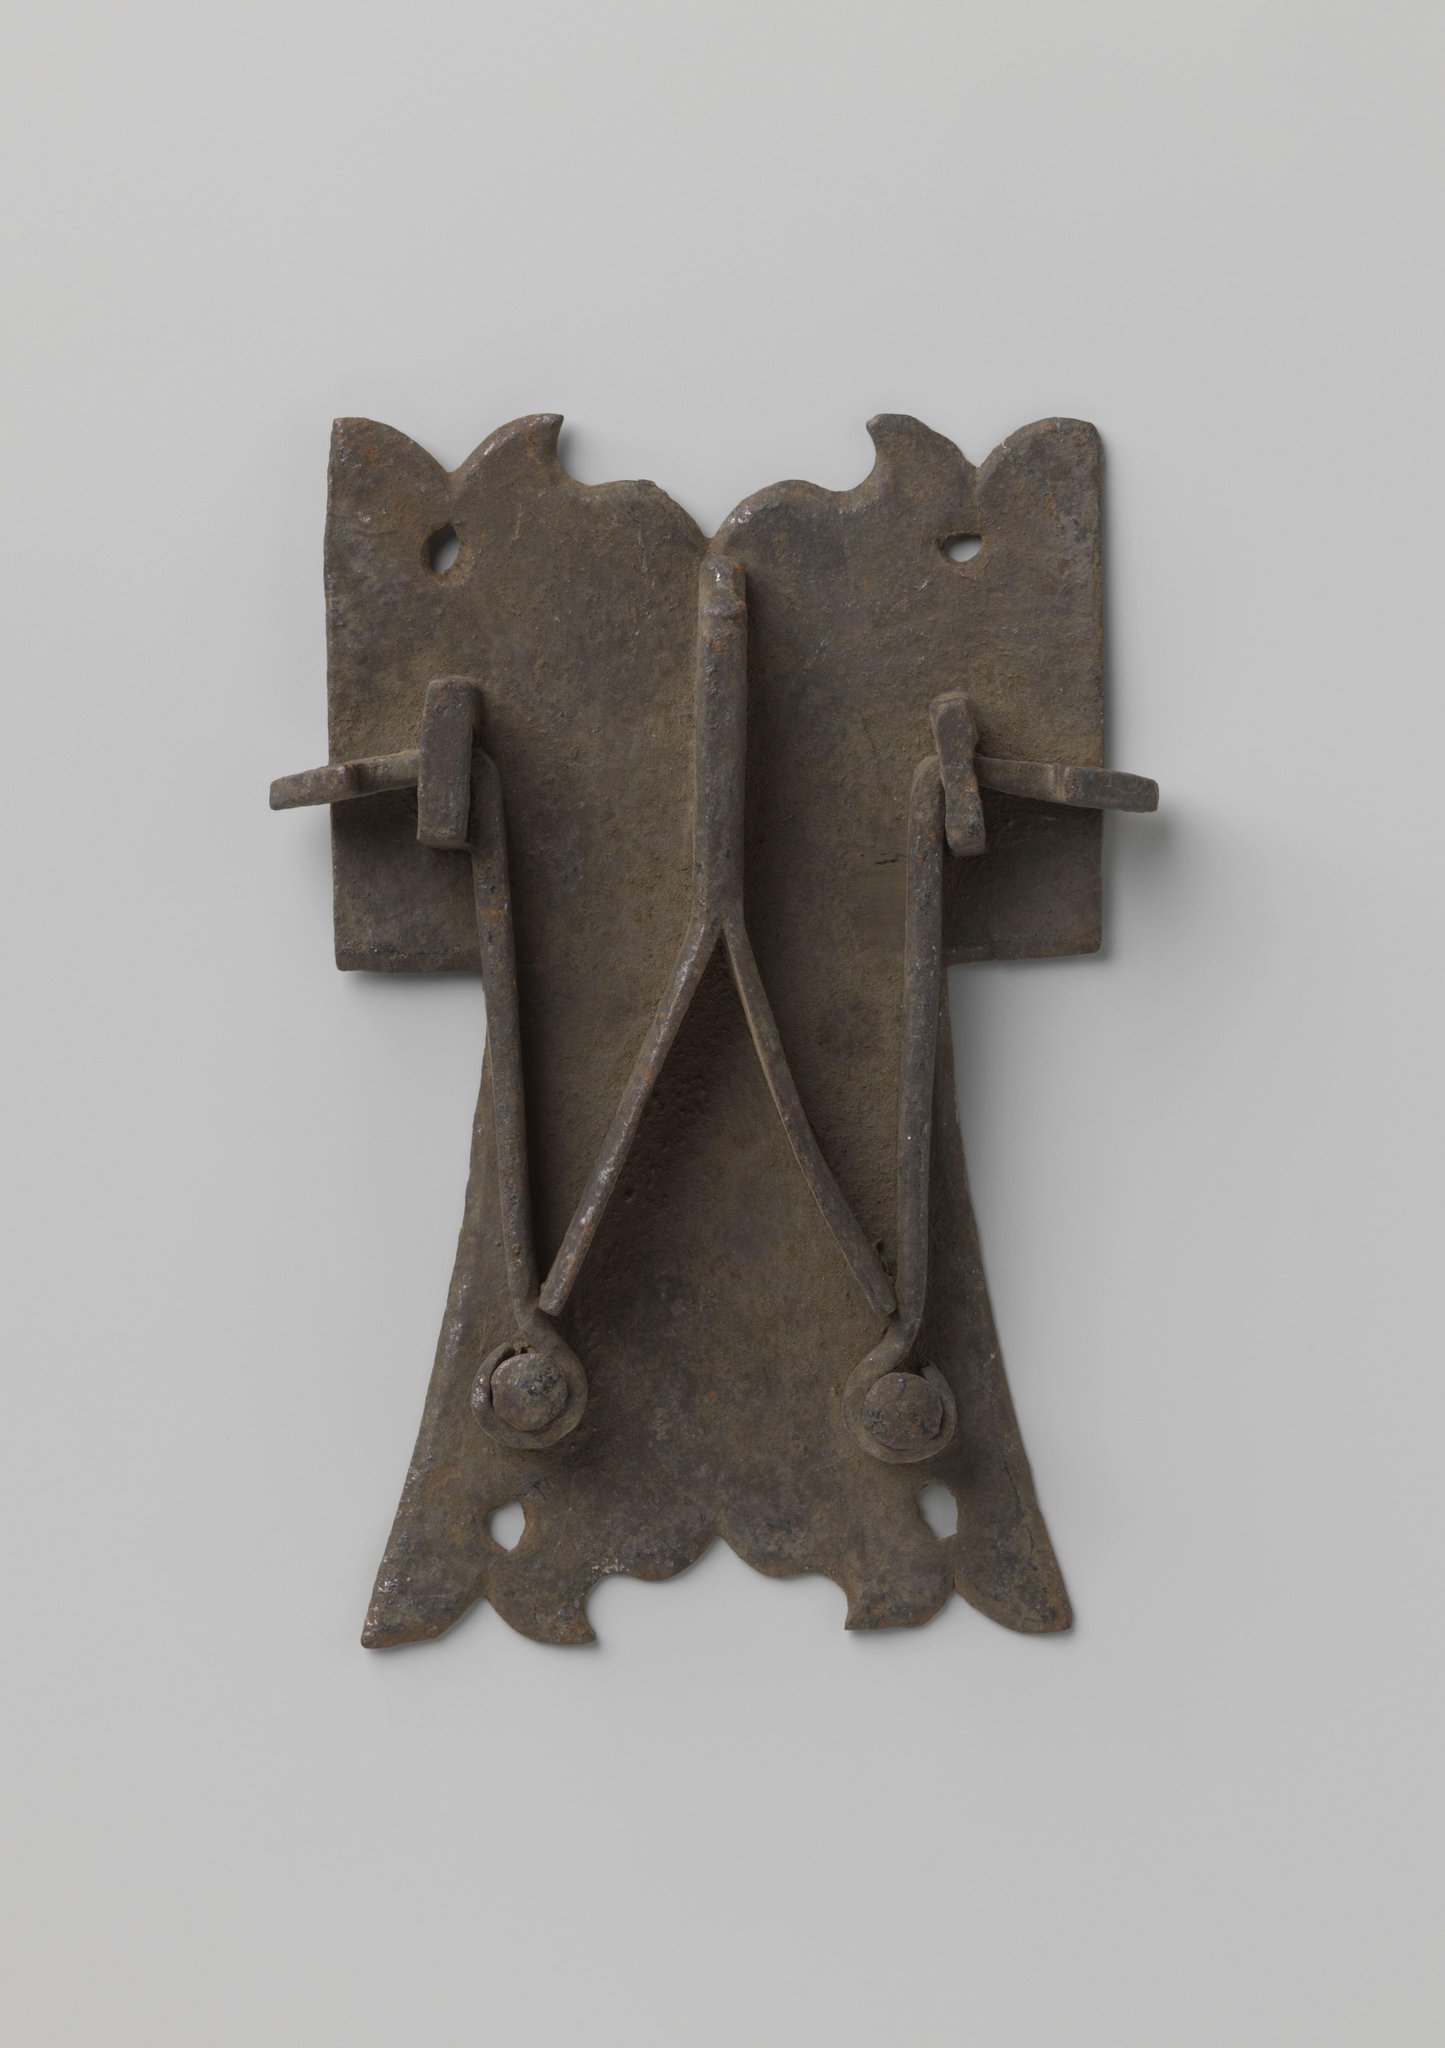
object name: knip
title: Dubbele knip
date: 1400-1950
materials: iron